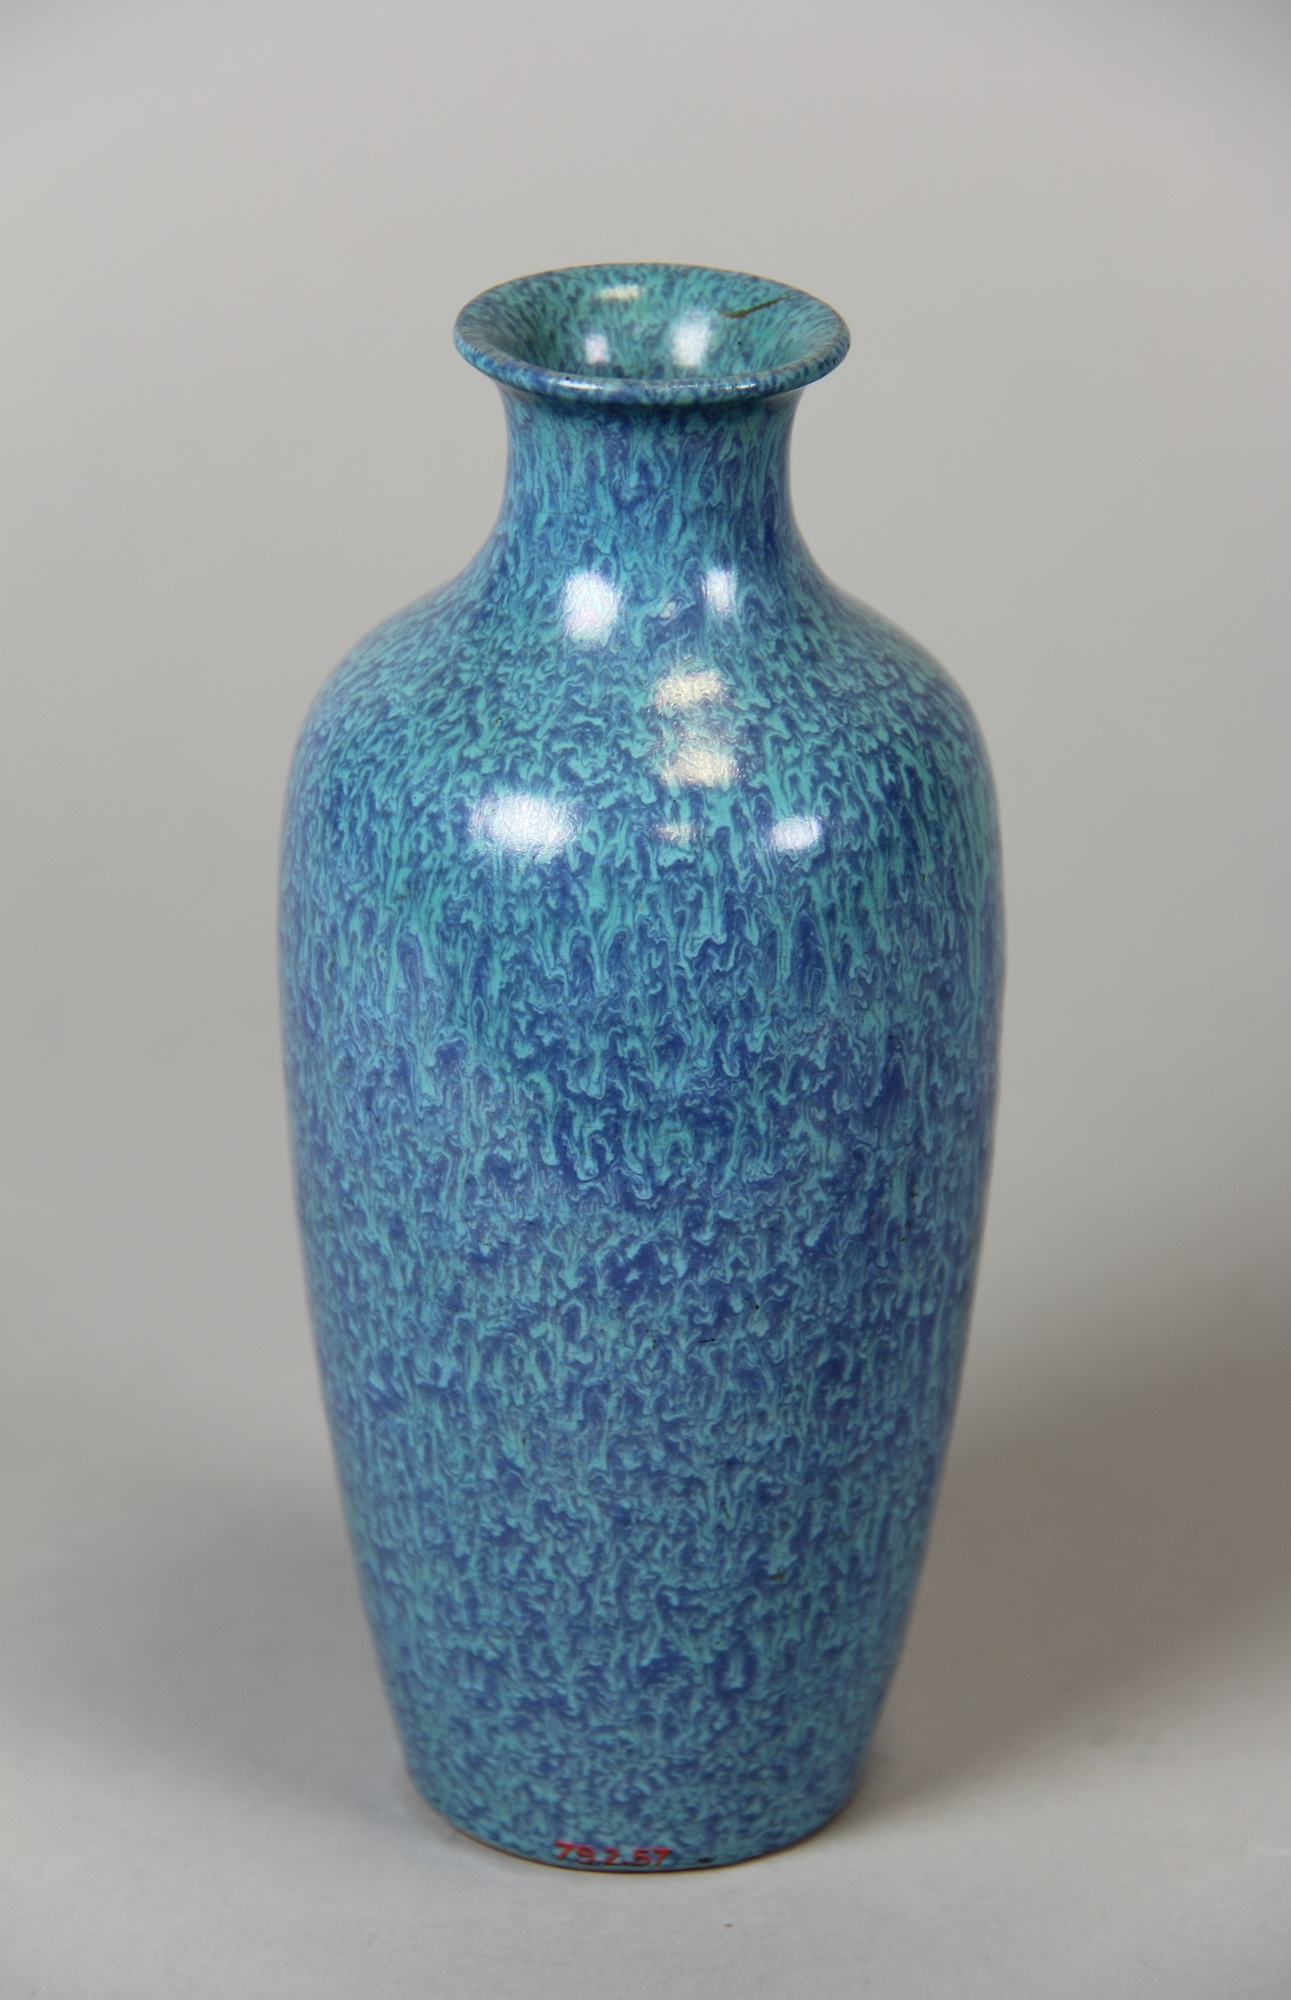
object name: vase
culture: chinese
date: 1644-1911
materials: glaze, porcelain